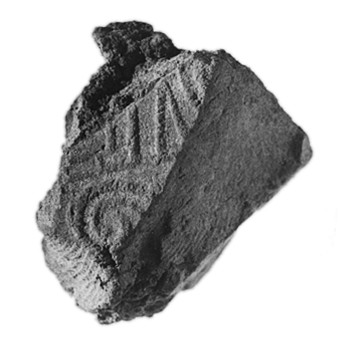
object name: sealing fragment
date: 2030-1640 BCE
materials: clay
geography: egypt